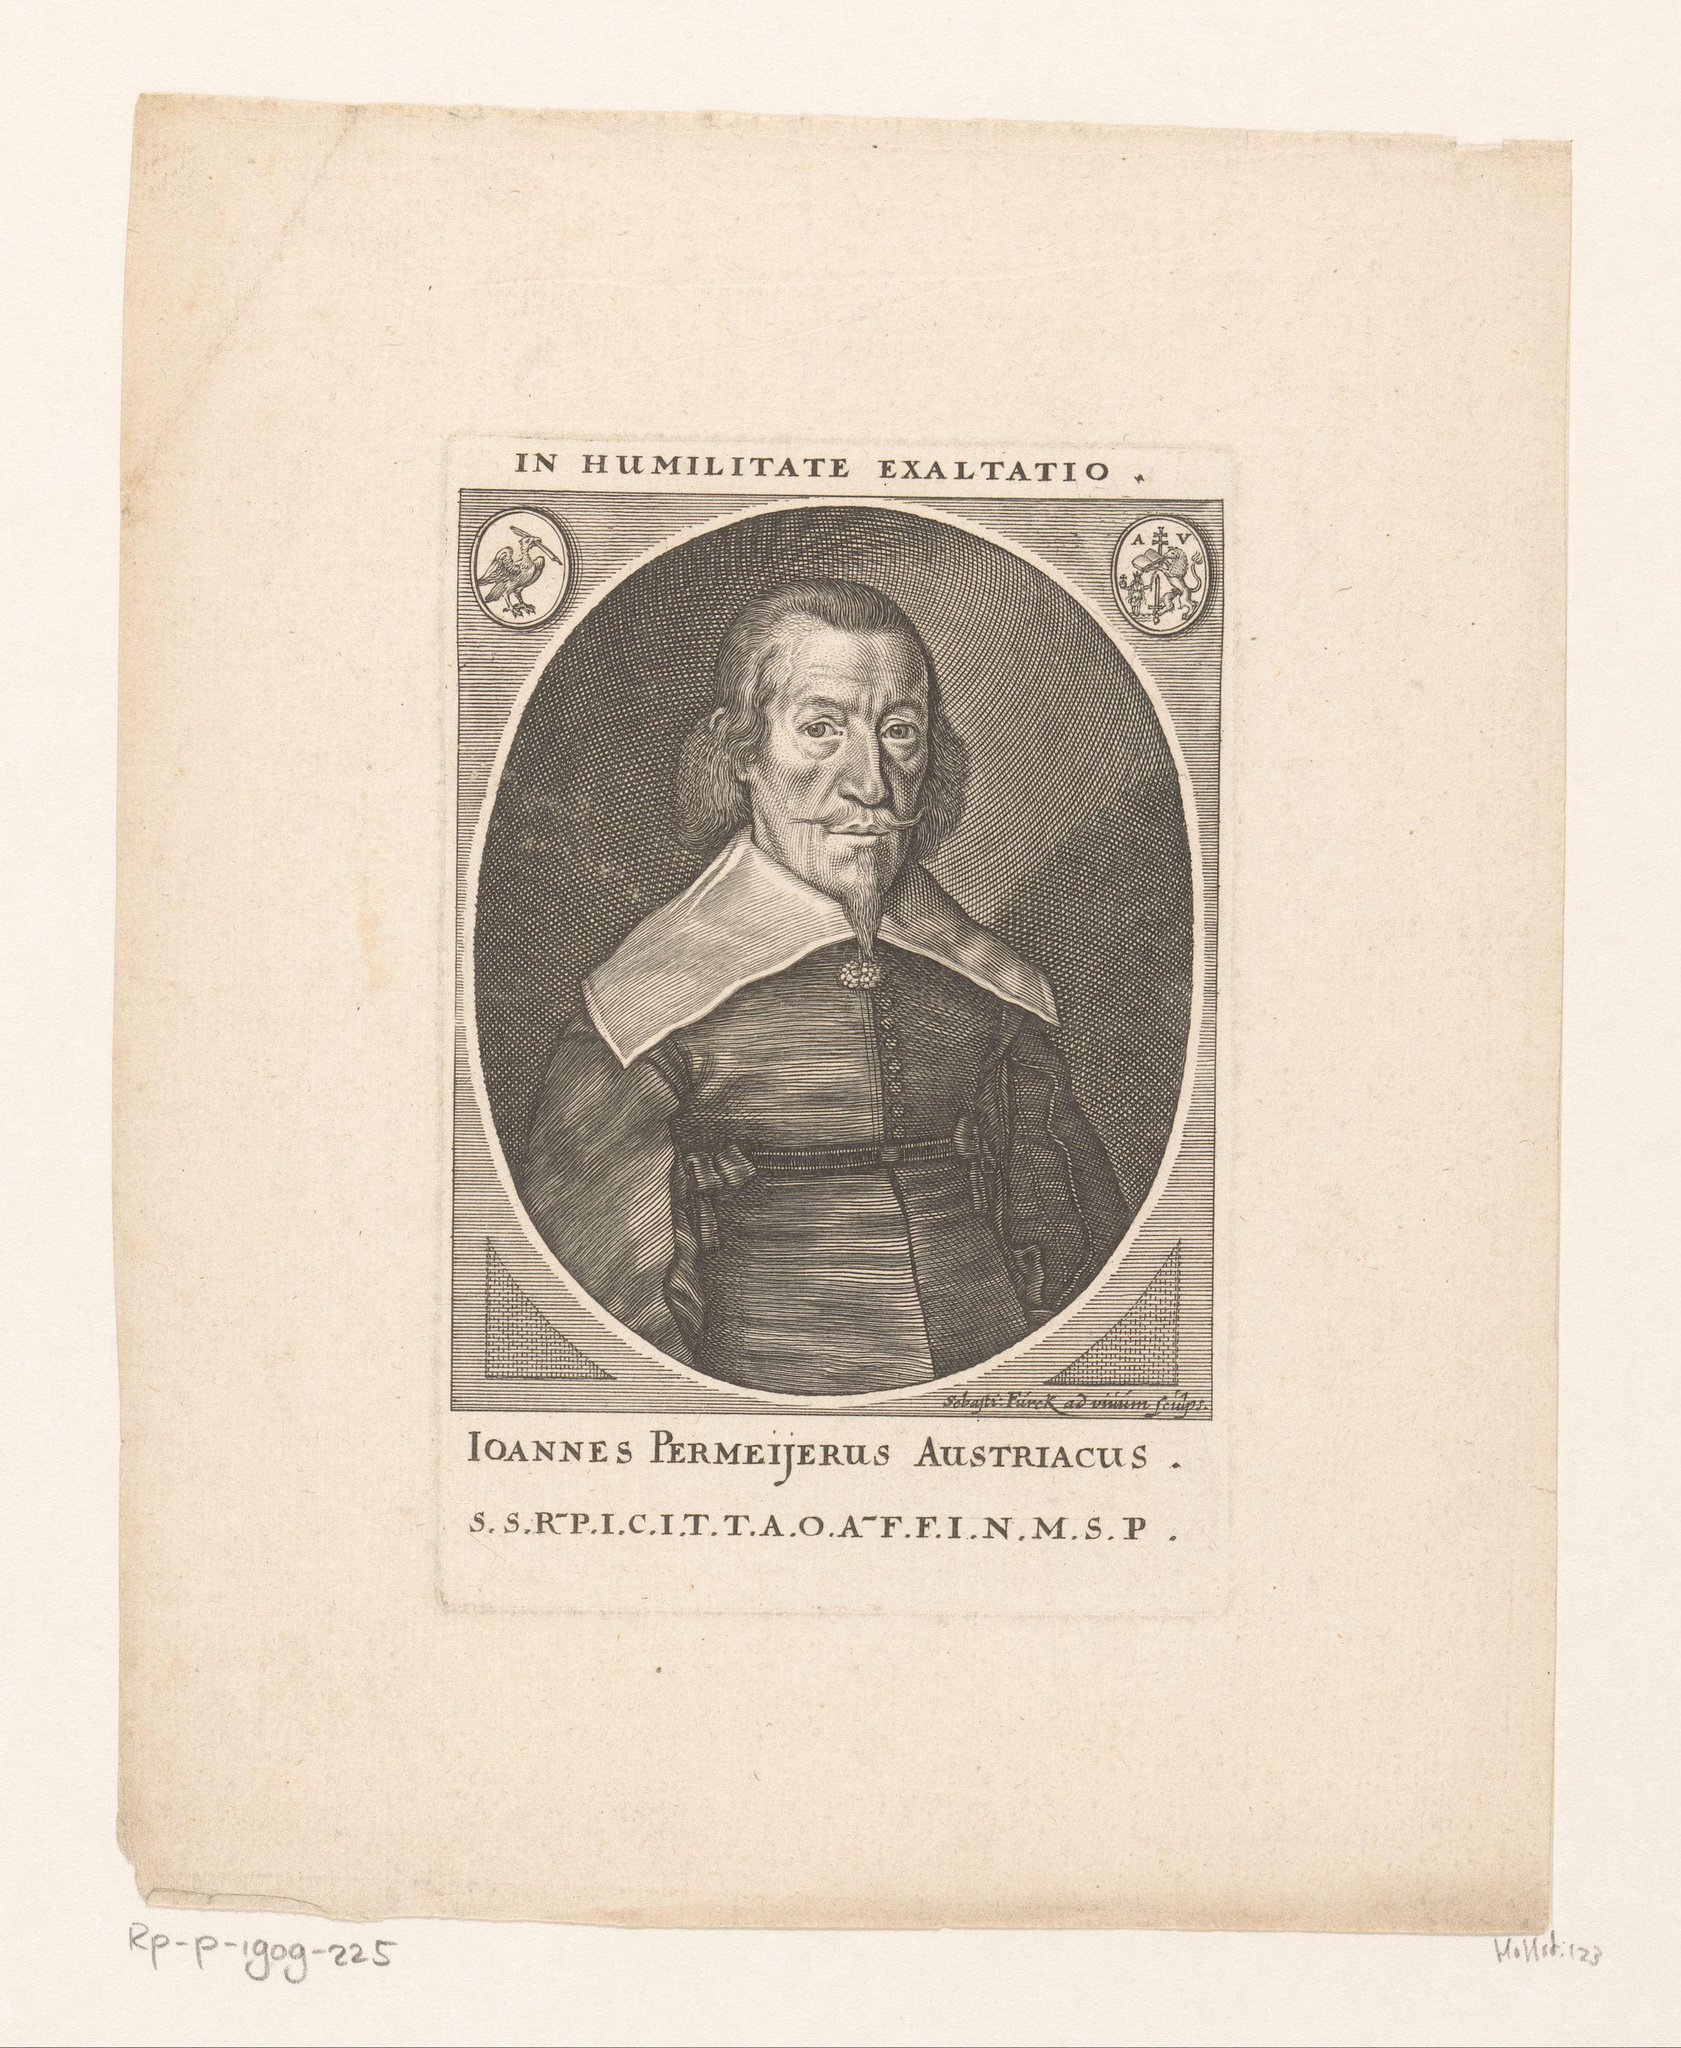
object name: print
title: Portret van Johann Permeier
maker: sebastian furck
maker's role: print maker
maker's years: 1600-1655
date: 1610-1640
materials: paper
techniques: engraving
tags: theologian, historical persons, abstract ideas and concepts (+ emblematical representation of concept)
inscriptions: collector's mark: Lugt 2228